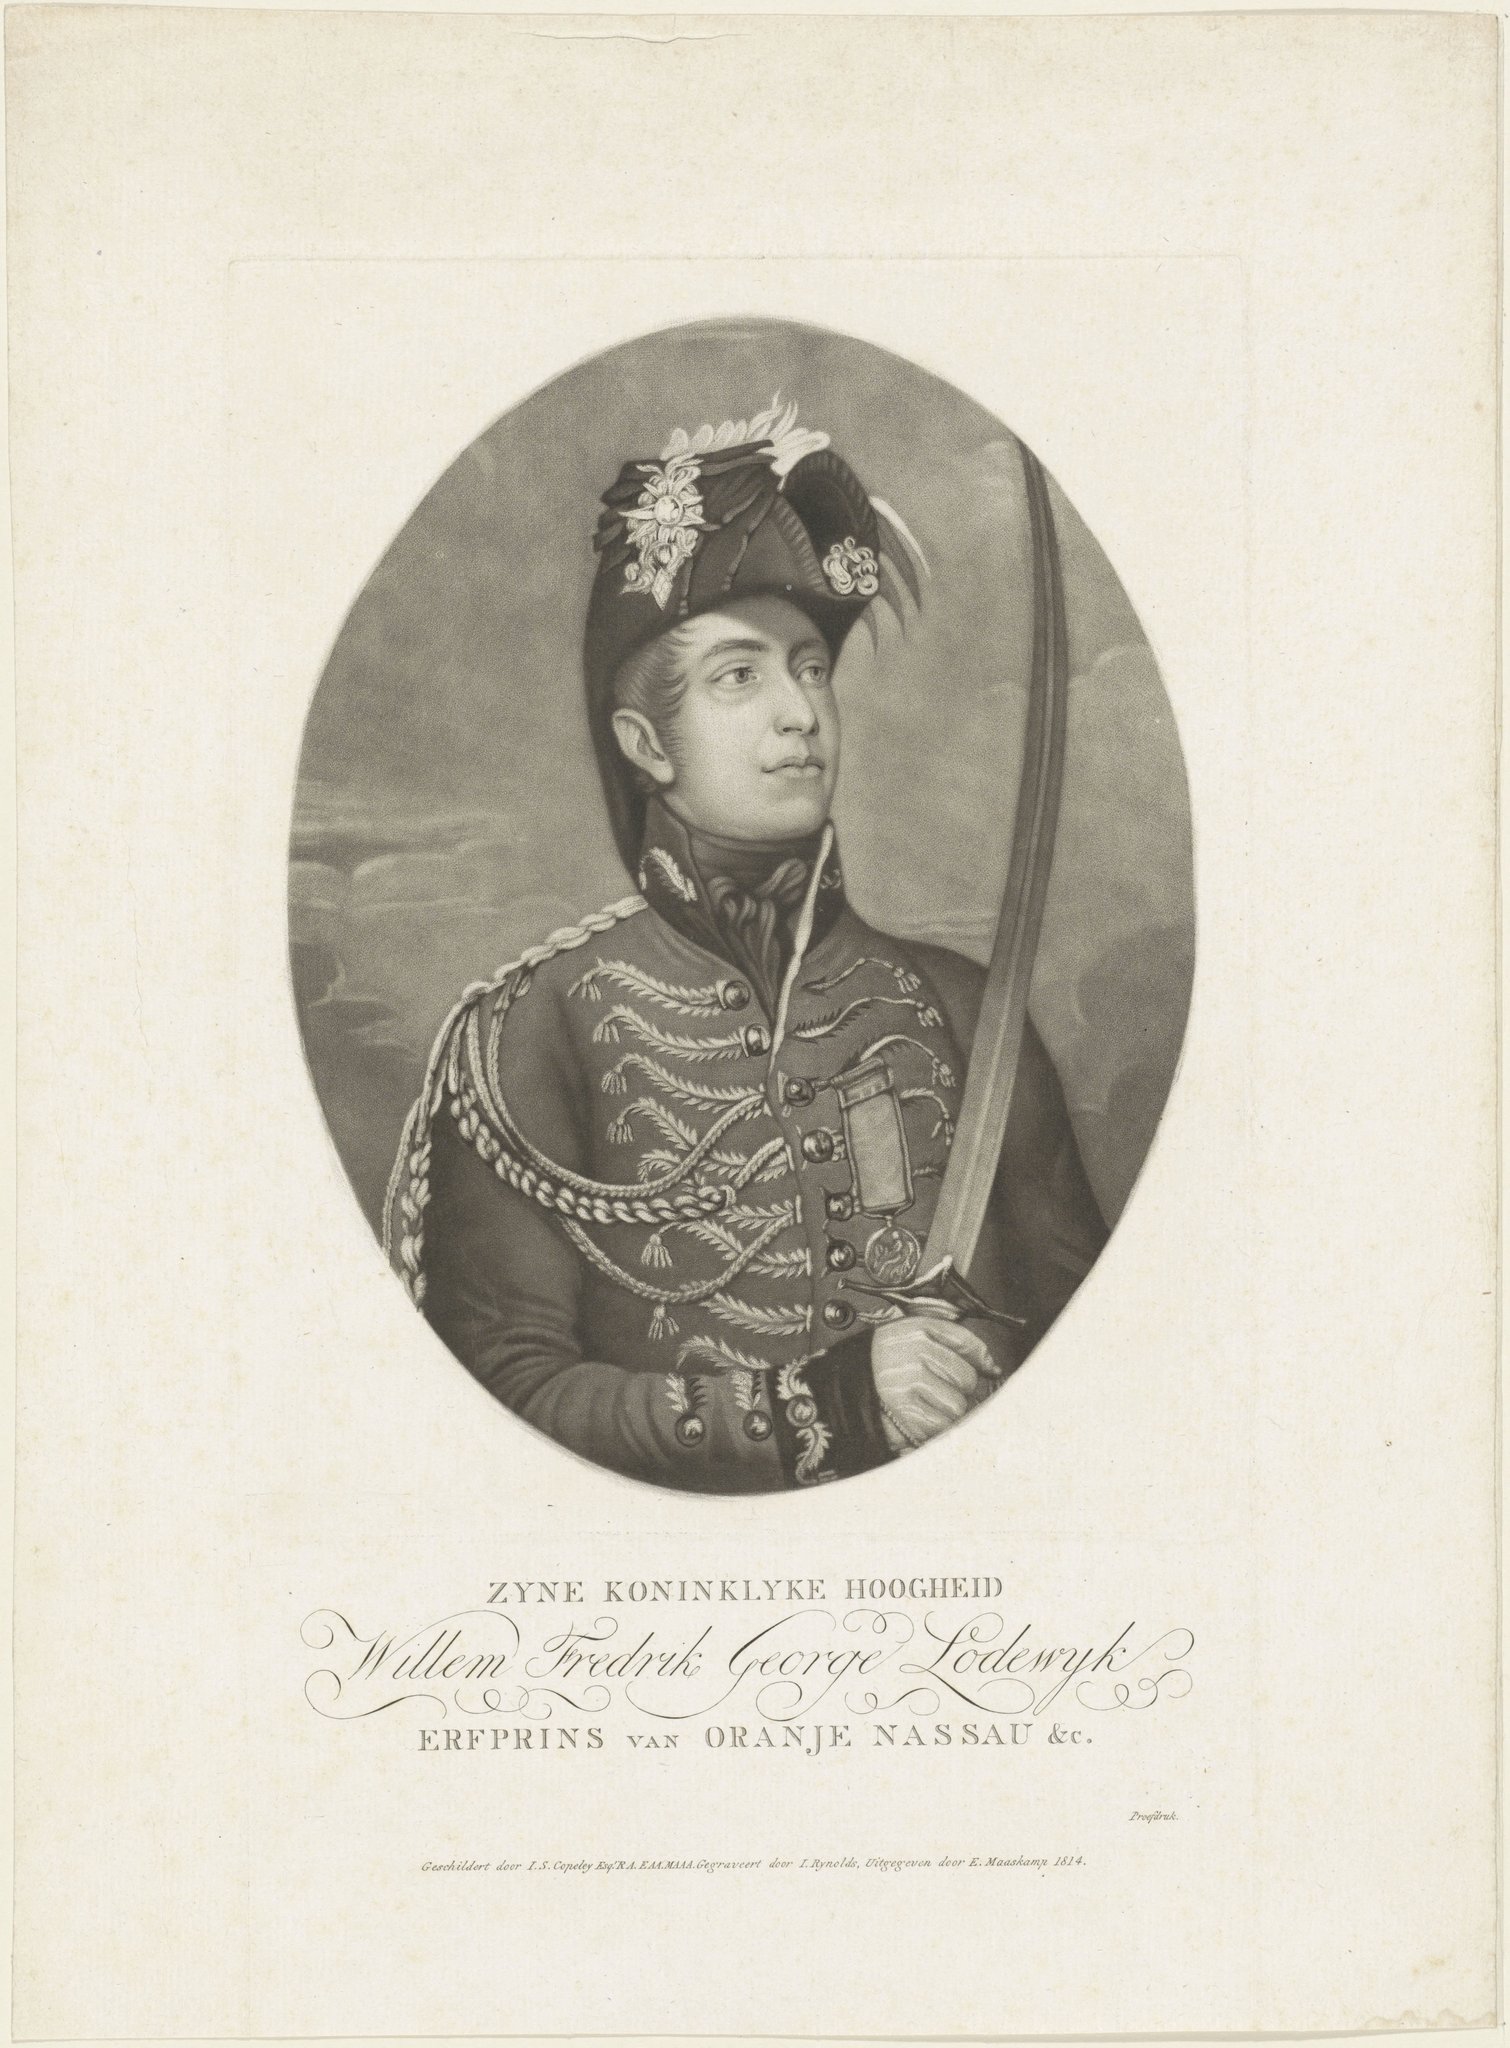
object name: print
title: Portret van Willem II, koning der Nederlanden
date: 1814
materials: paper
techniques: aquatint, etching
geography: netherlands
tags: the hague, william ii of the netherlands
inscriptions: date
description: De hier vermelde titel verwijst naar de hoogst verkregen titel van de geportretteerde, niet per se naar de titel die de geportretteerde op deze voorstelling draagt.